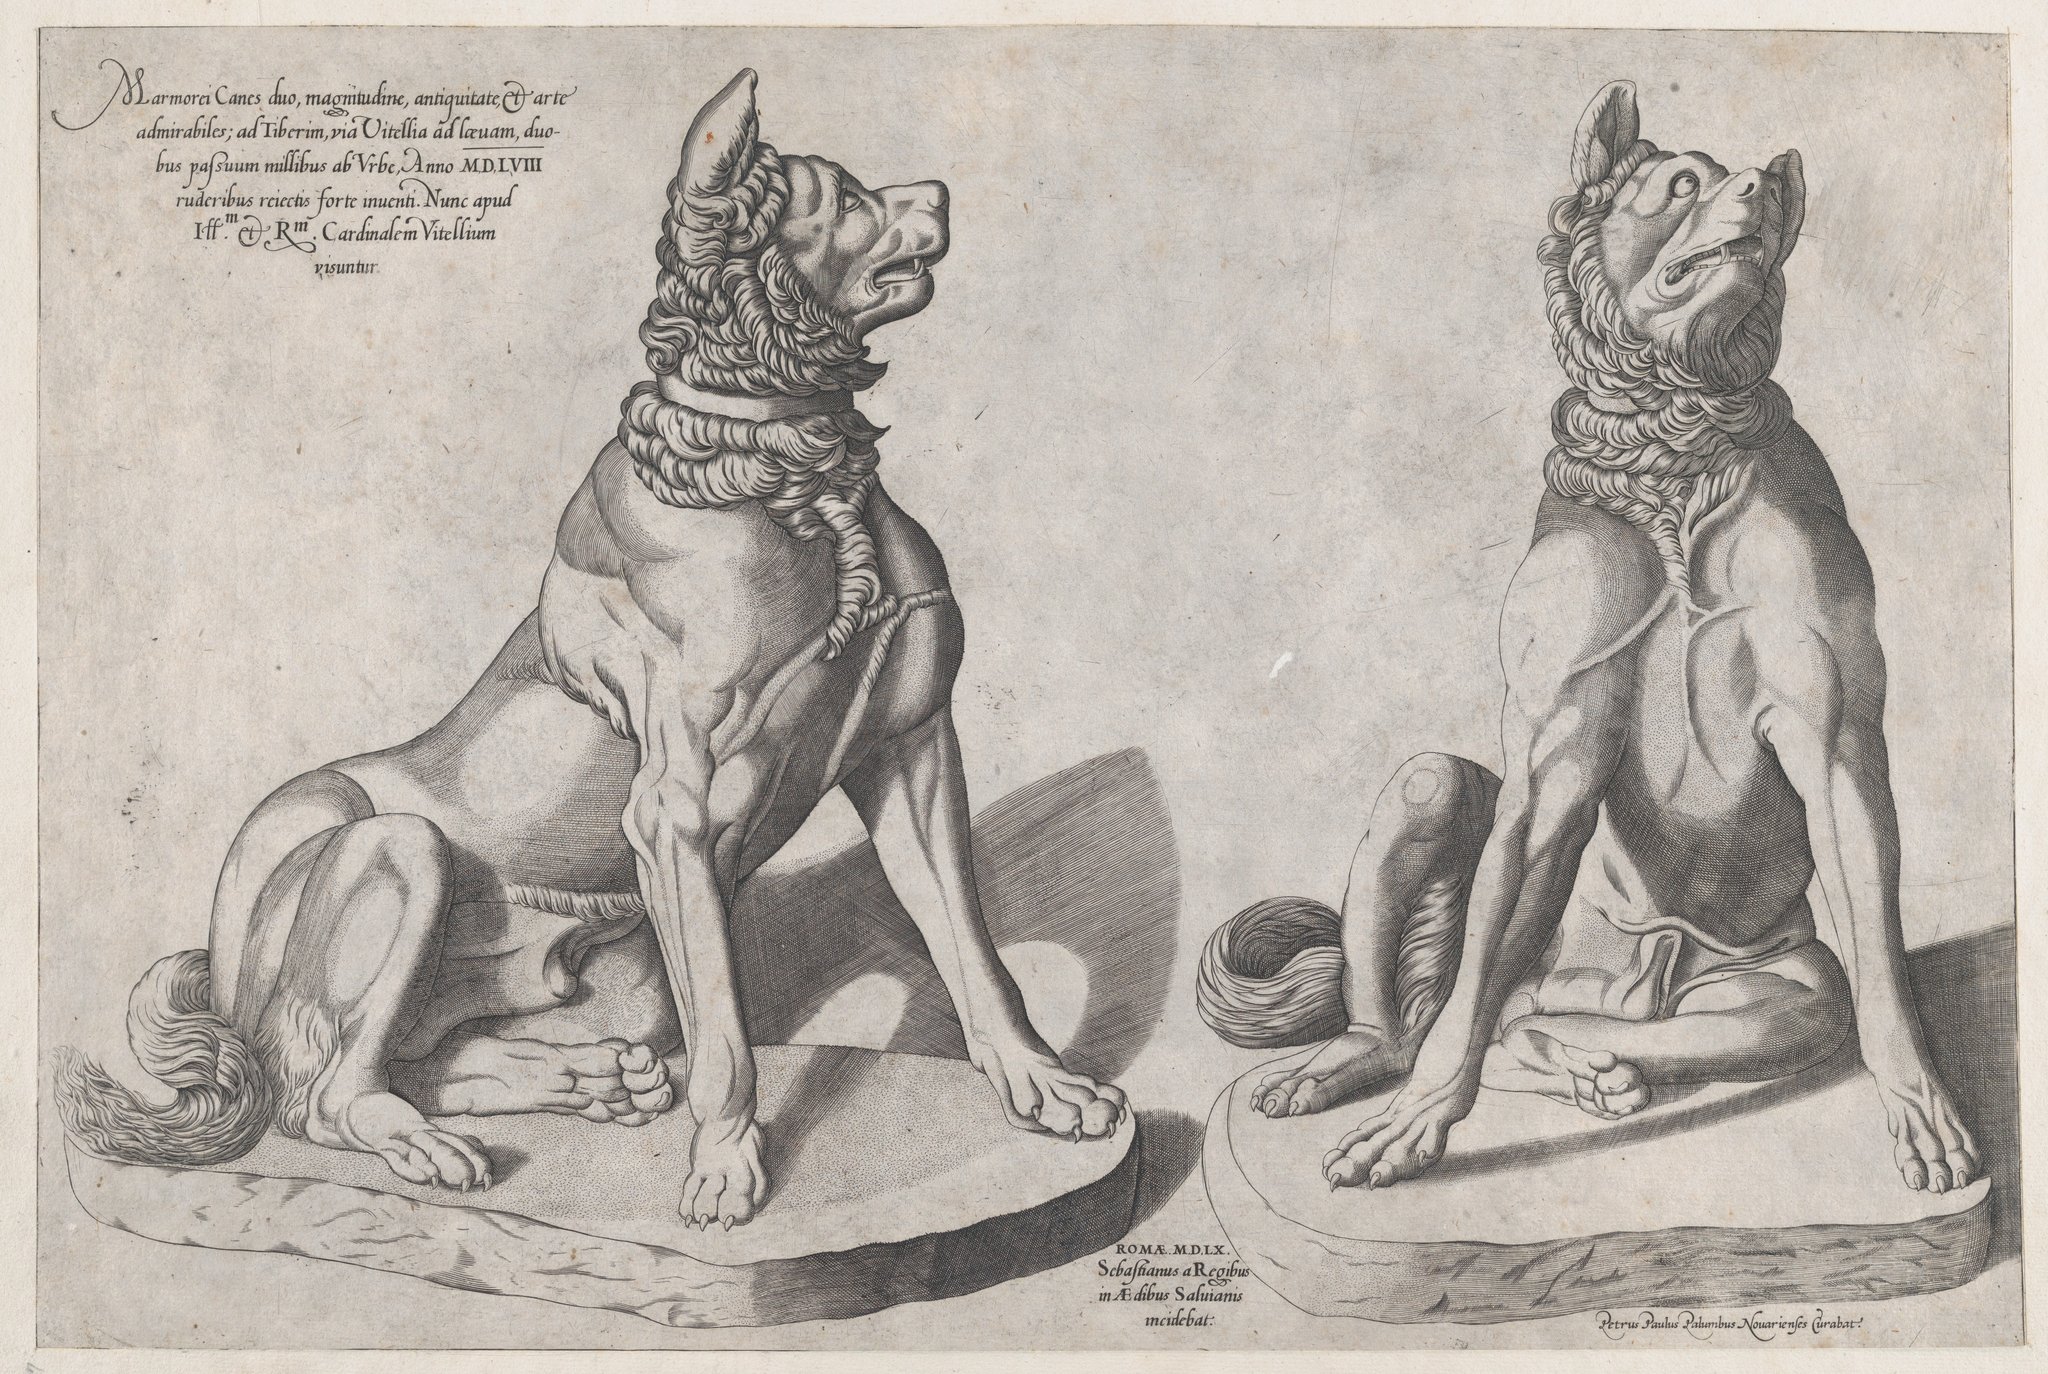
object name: print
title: Two Dogs, from "Speculum Romanae Magnificentiae"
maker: sebastiano di re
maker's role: artist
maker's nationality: italian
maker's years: 1557-1563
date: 1558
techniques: engraving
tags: dogs